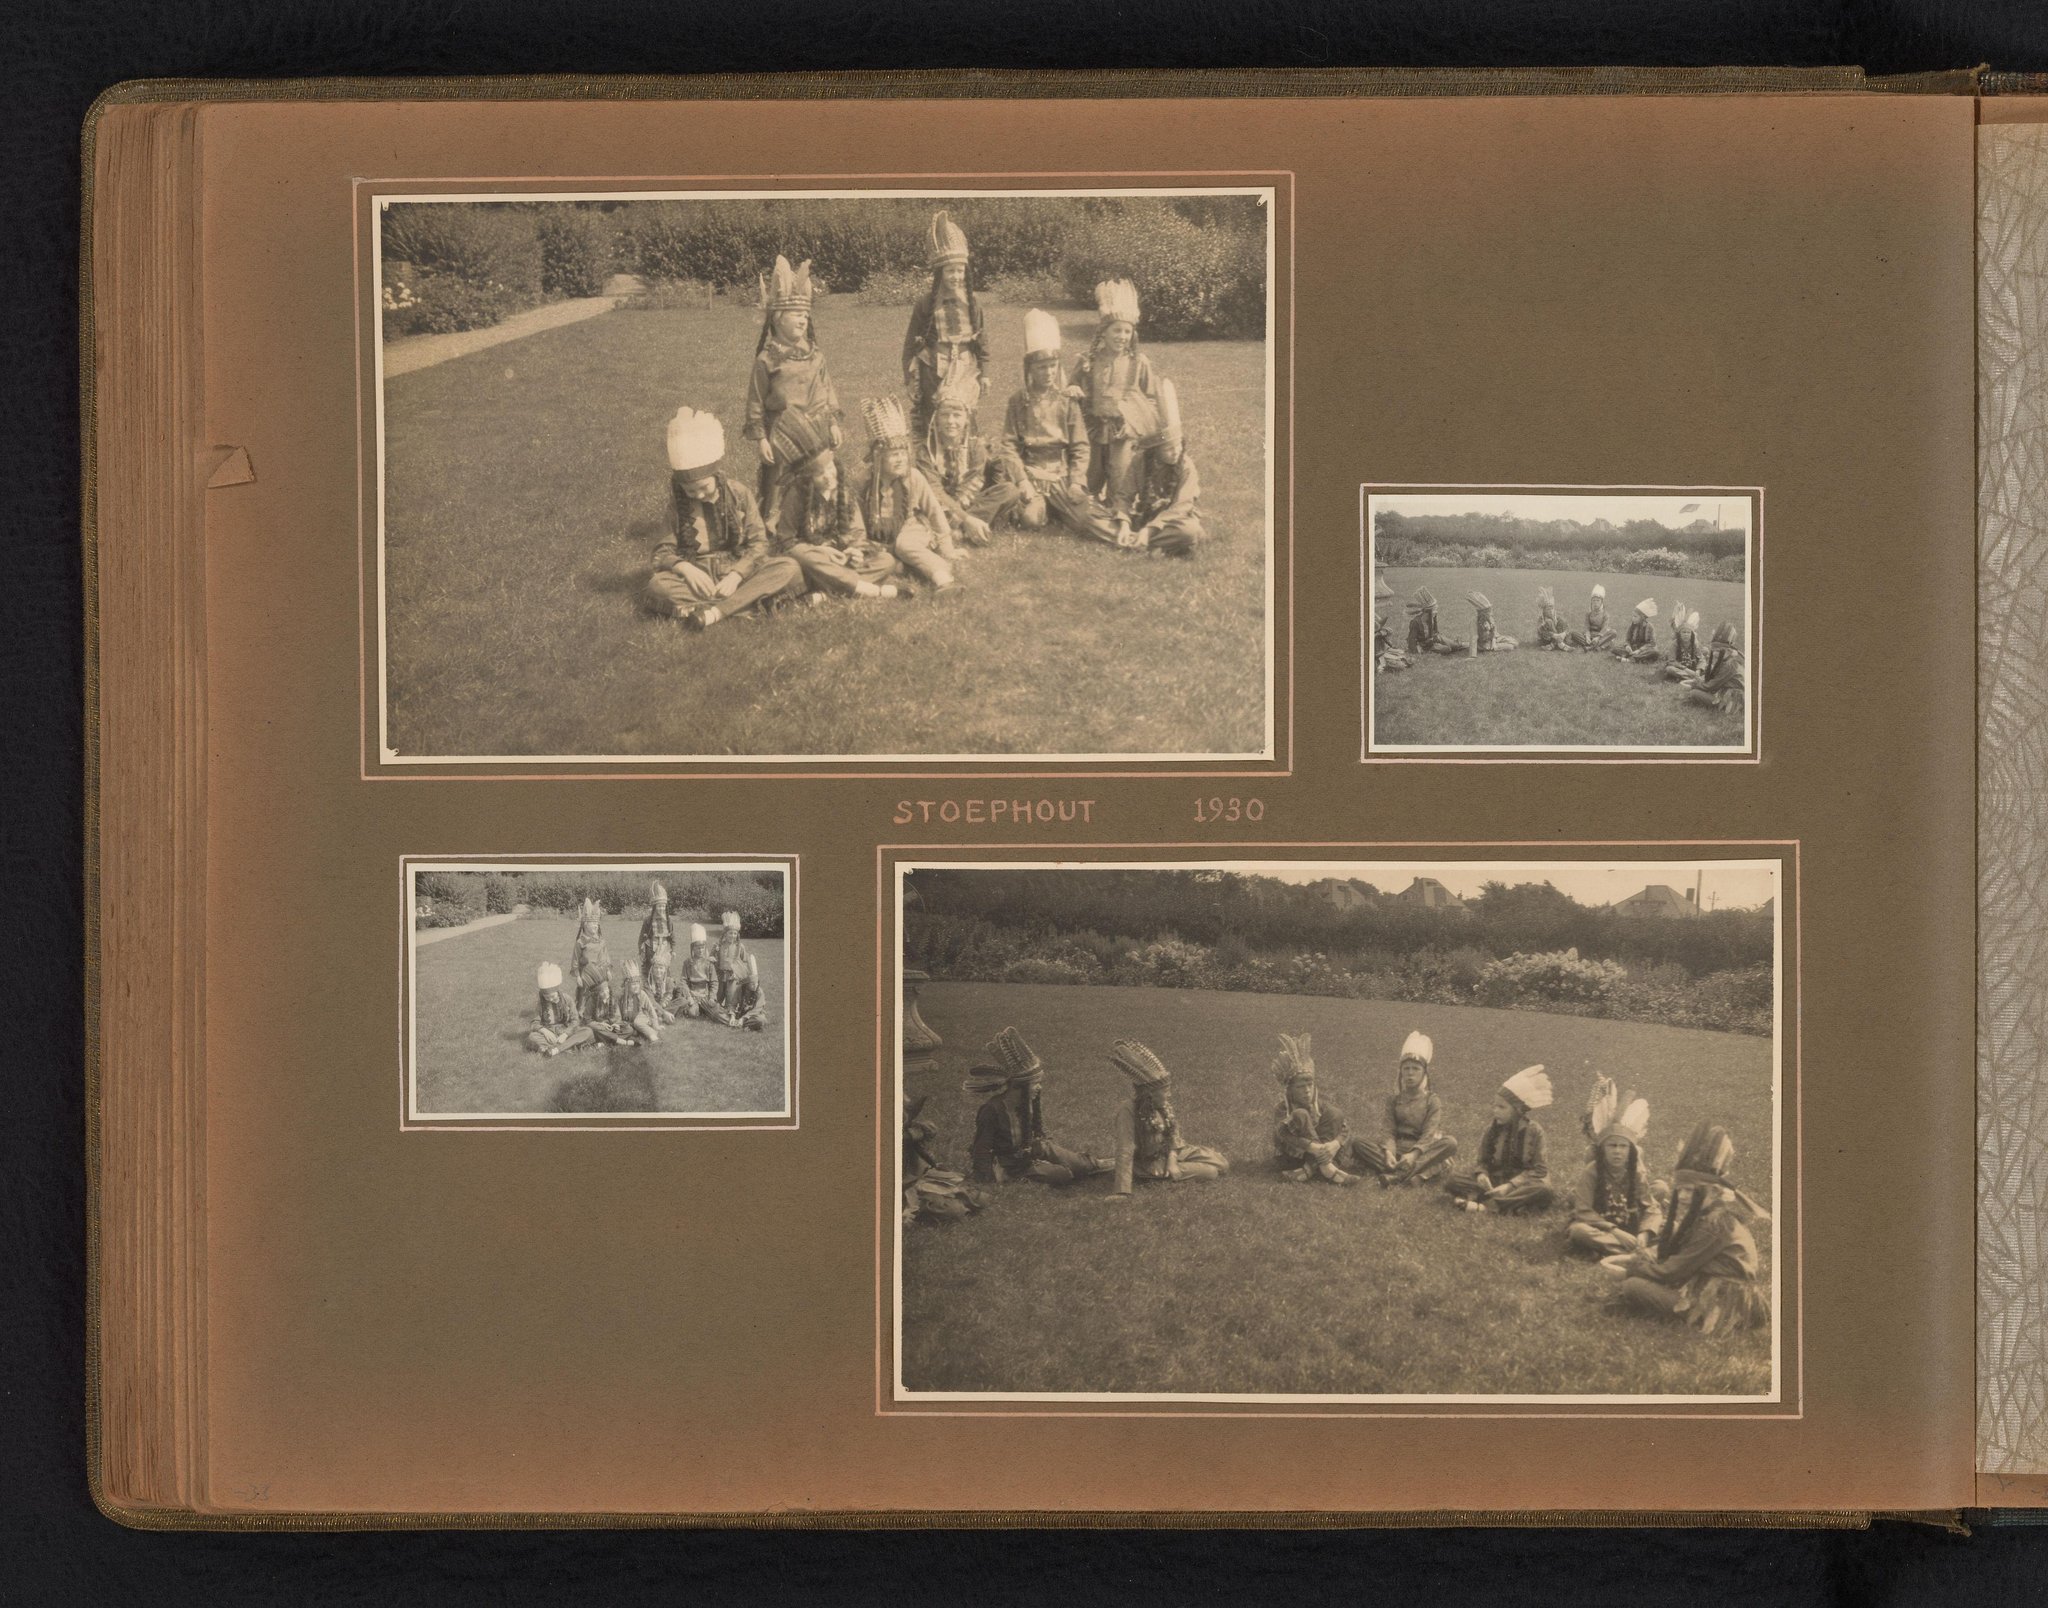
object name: album leaf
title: Stoephout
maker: Anonymous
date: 1930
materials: paper, cardboard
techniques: gelatin silver print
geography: wassenaar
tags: children's games and plays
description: Deze foto's zijn onderdeel van een album.